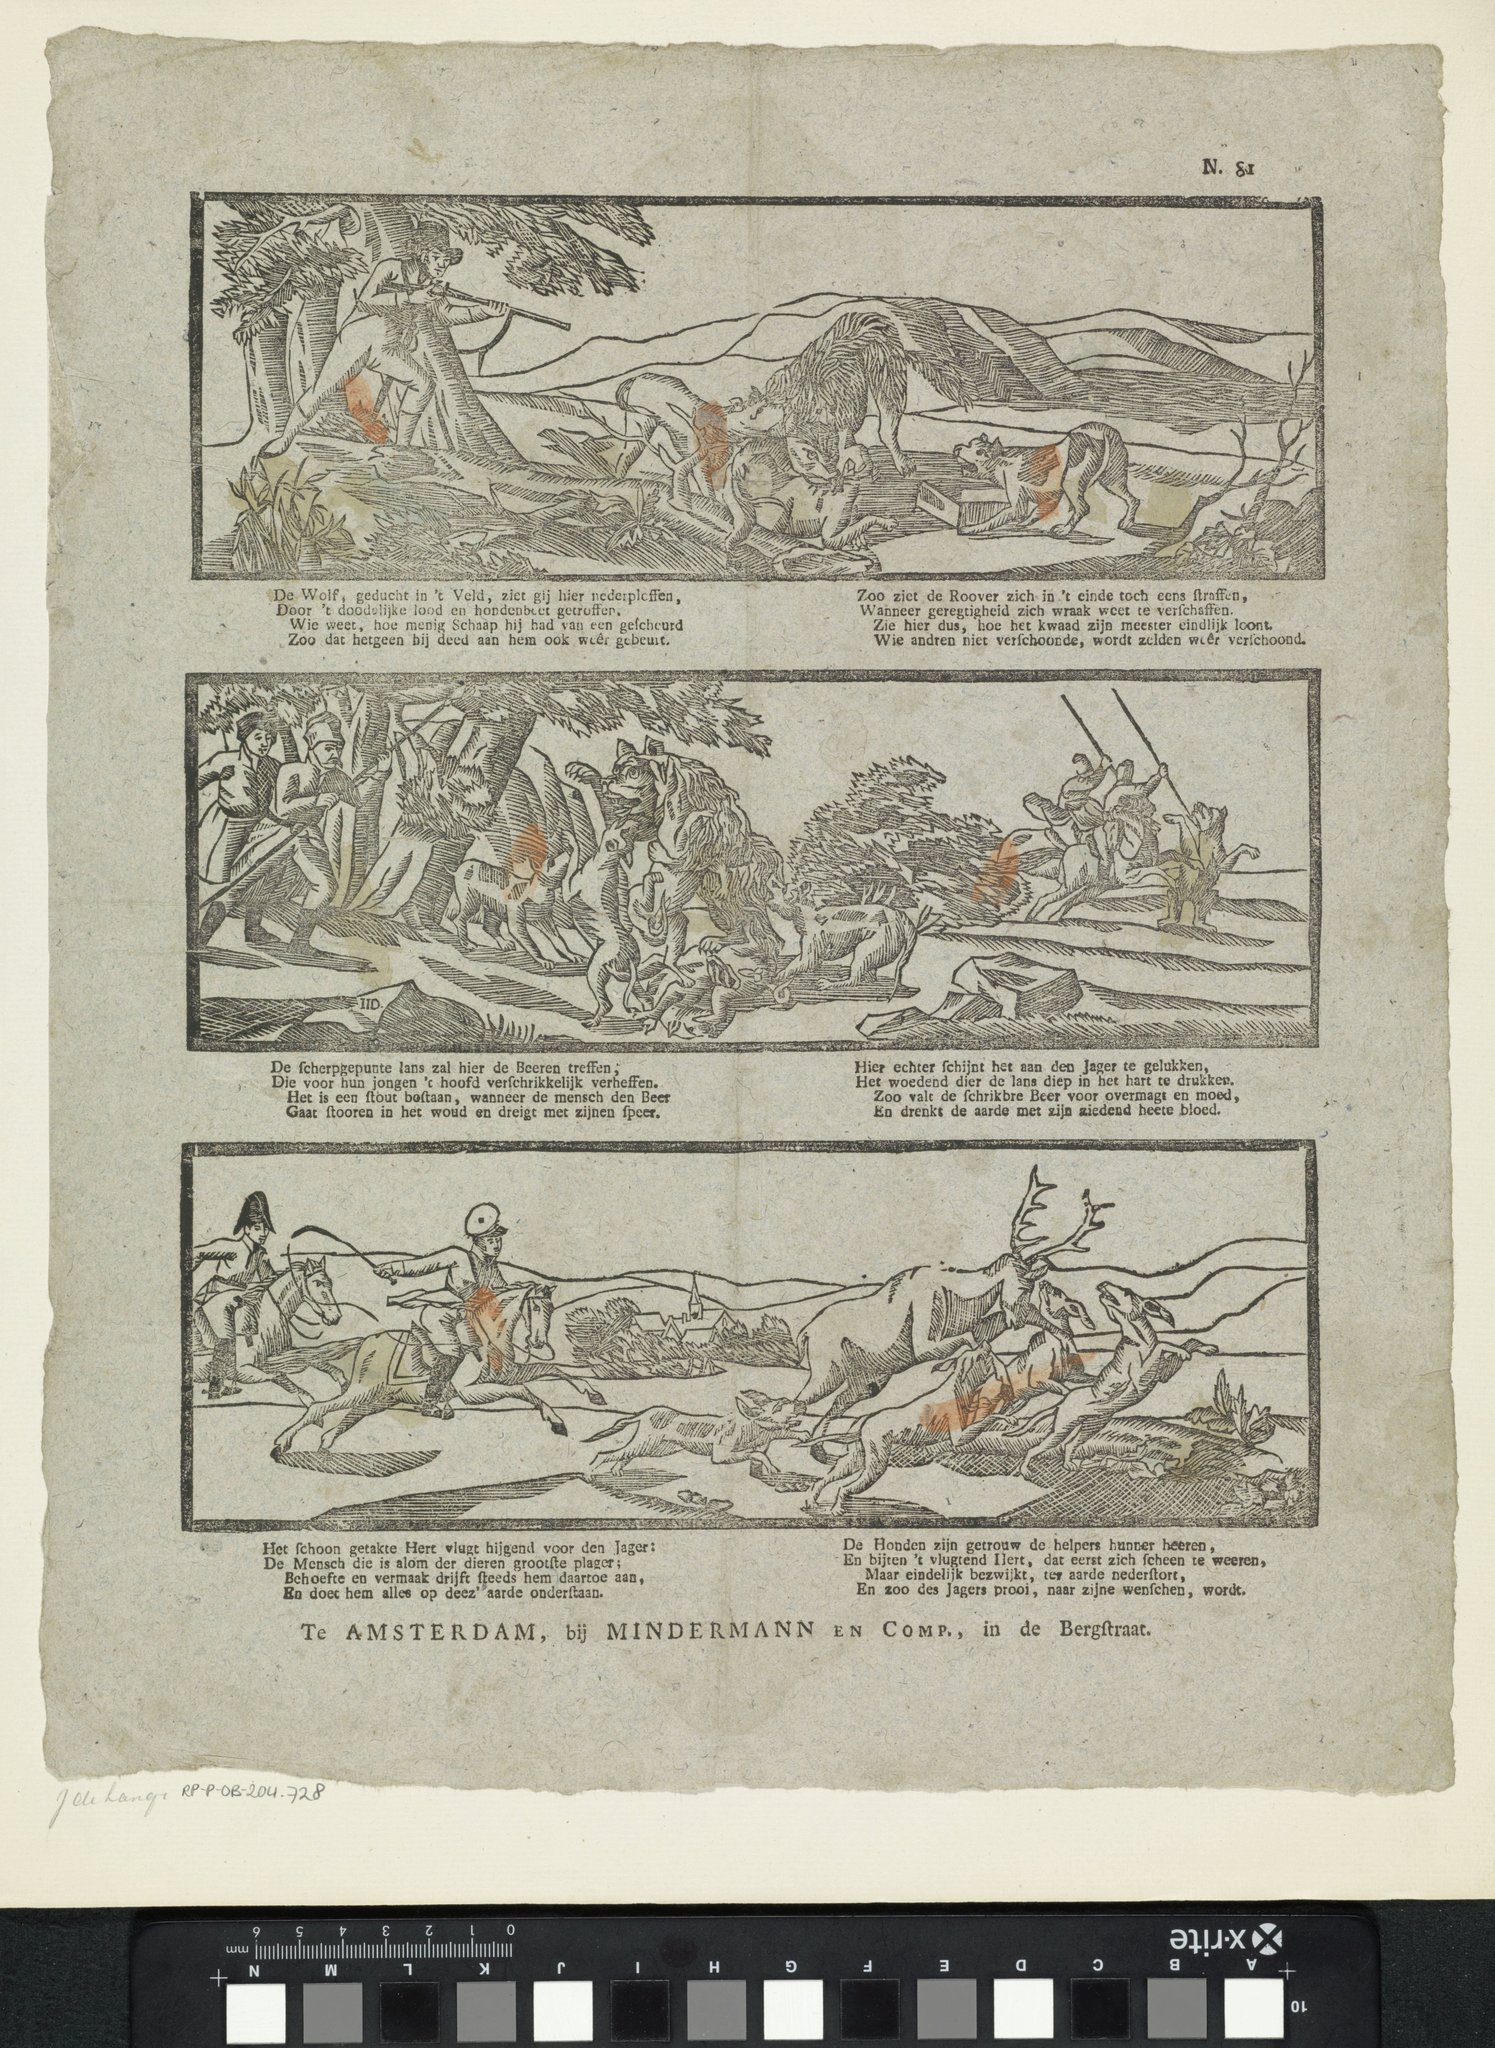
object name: print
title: Jachttaferelen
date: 1822-1849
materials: paper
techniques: colour, letterpress printing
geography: deventer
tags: hunting dogs, hunter, hunters hunting (n.b.: in 1988-1990 this notation denoted the concept of 43c11421 'hunters resting during the hunt'), hunt ~ mammals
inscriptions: collector's mark: Lugt 2760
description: Blad met 3 voorstellingen van jachttaferelen. Onder elke afbeelding een achtregelig vers in twee kolommen. Genummerd rechtsboven: N. 81.